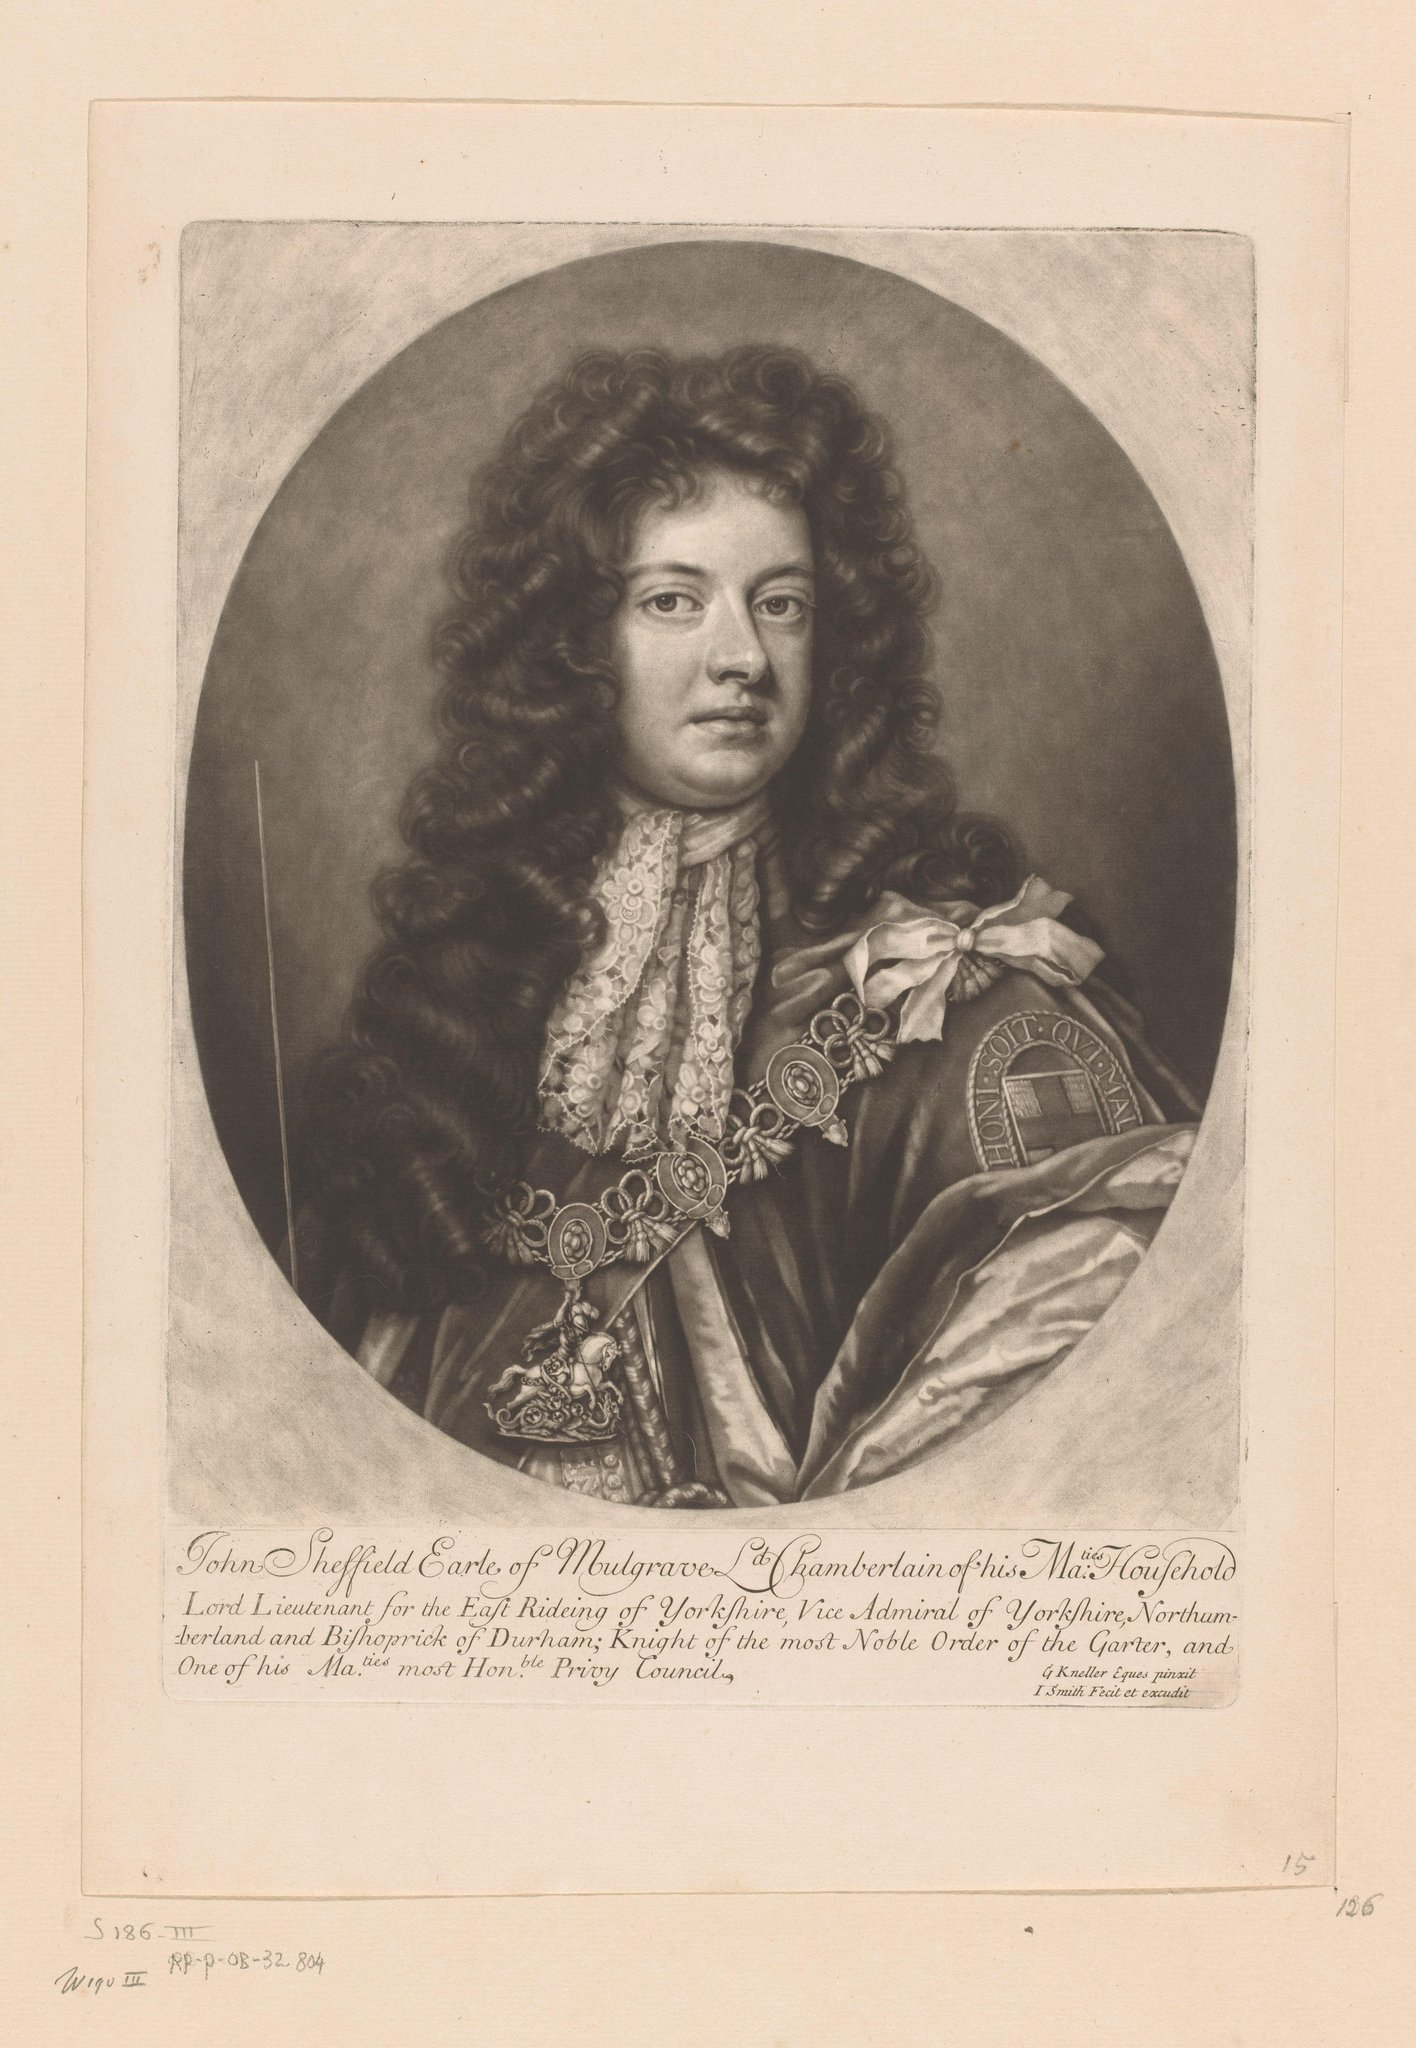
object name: print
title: Portret van John Sheffield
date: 1662-1742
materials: paper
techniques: mezzotint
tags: london, politician, historical persons, politician, e.g. party leader, writer, poet, author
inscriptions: collector's mark: Lugt 240